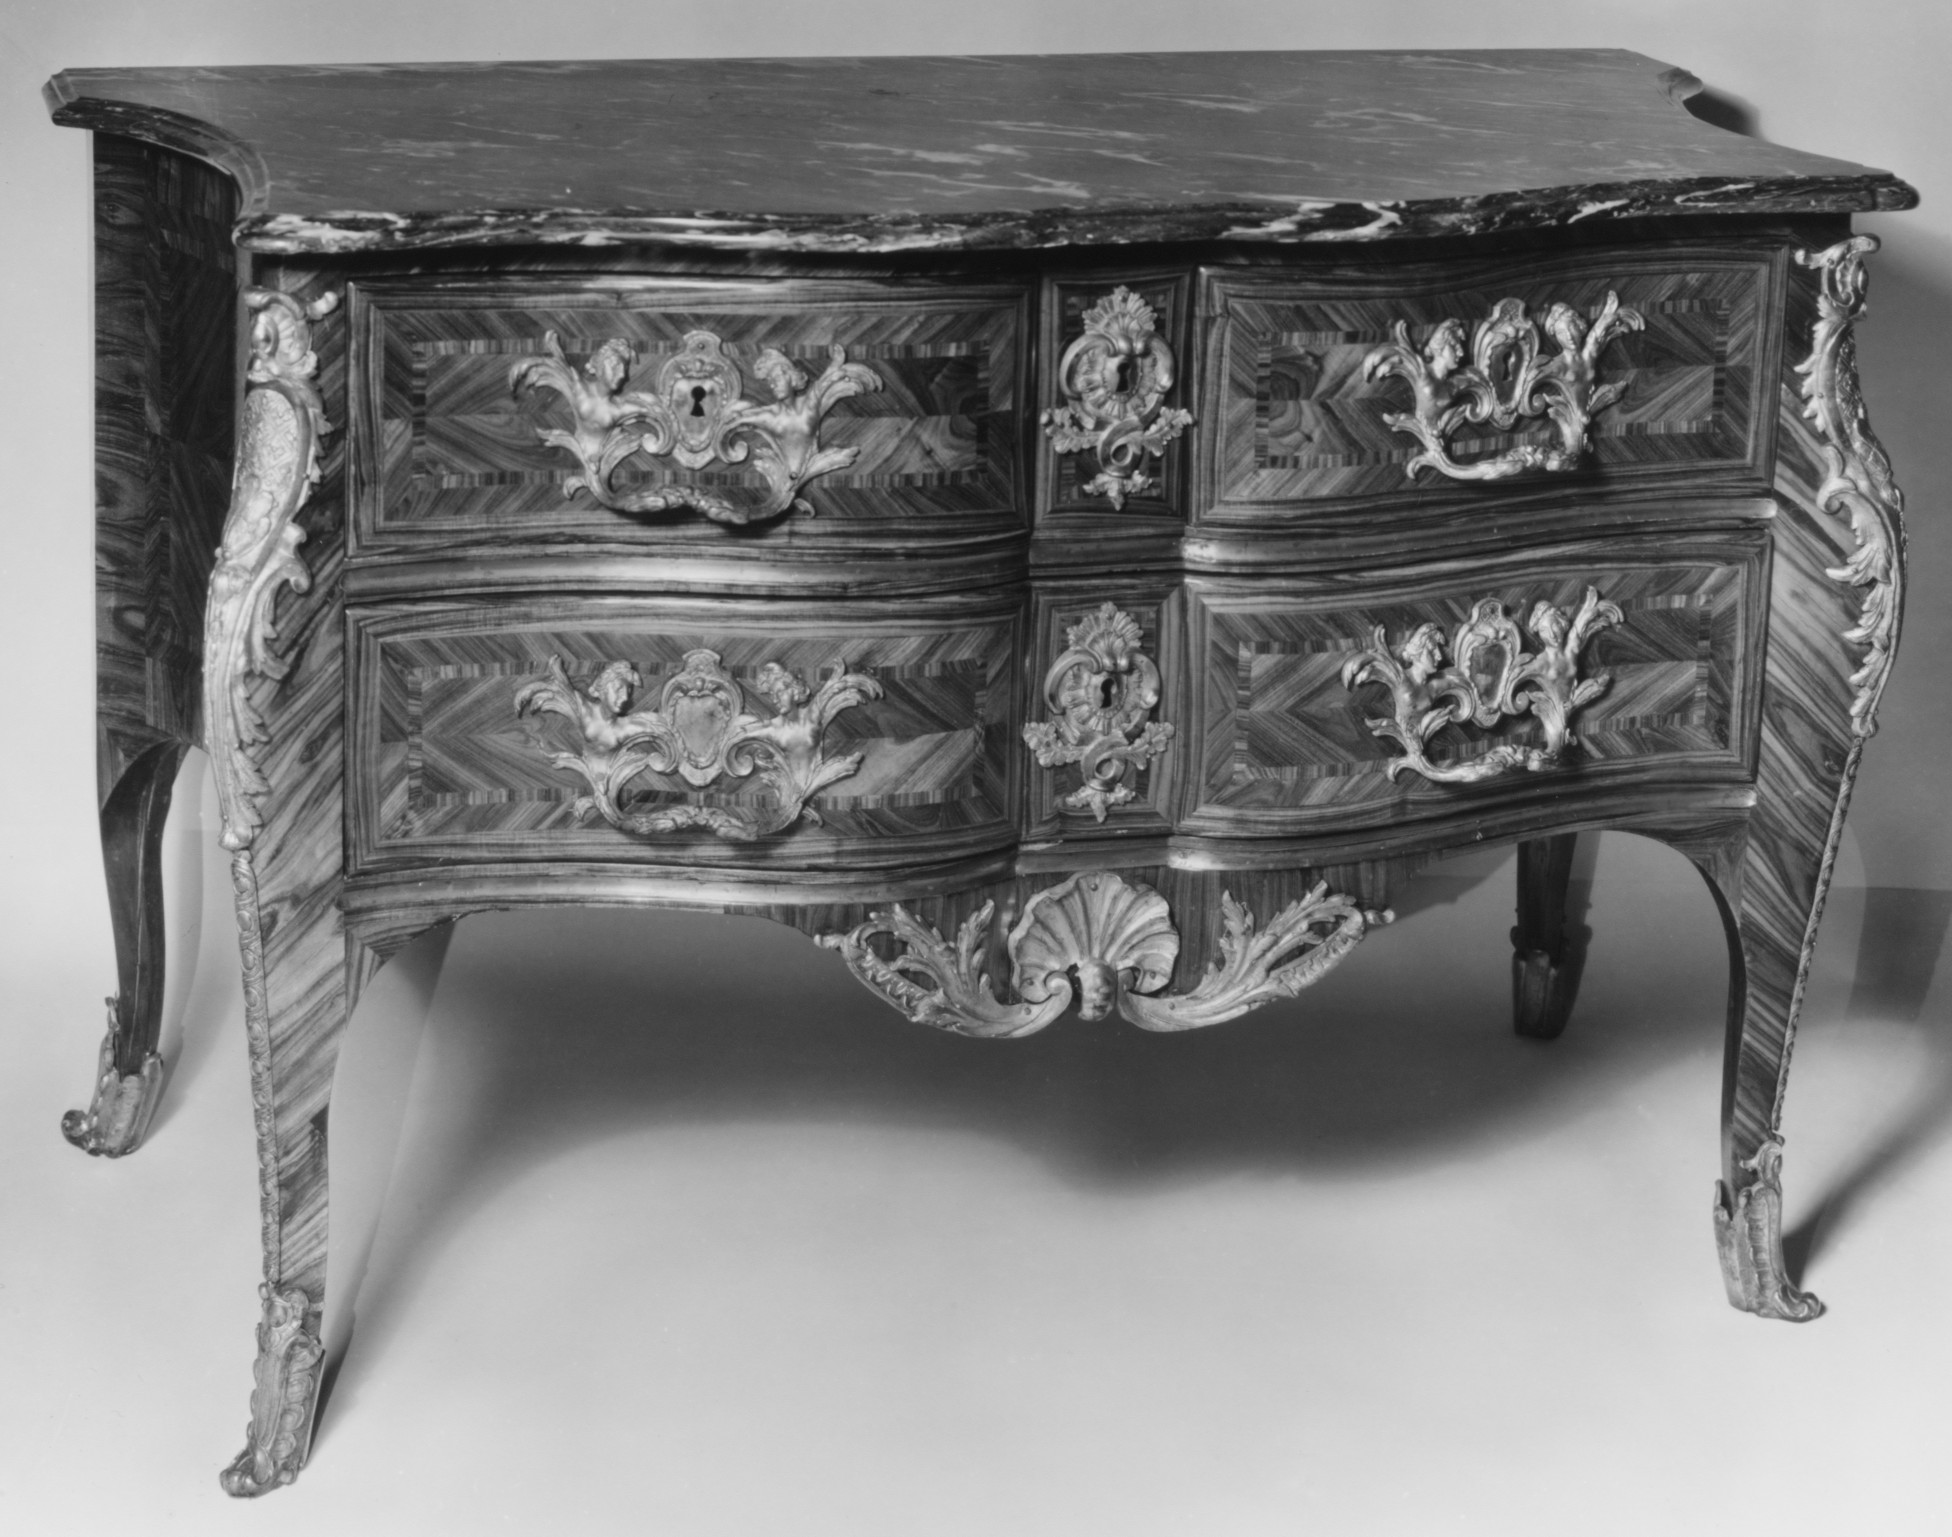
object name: commode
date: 1720-1730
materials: gilt bronze, marble, wood